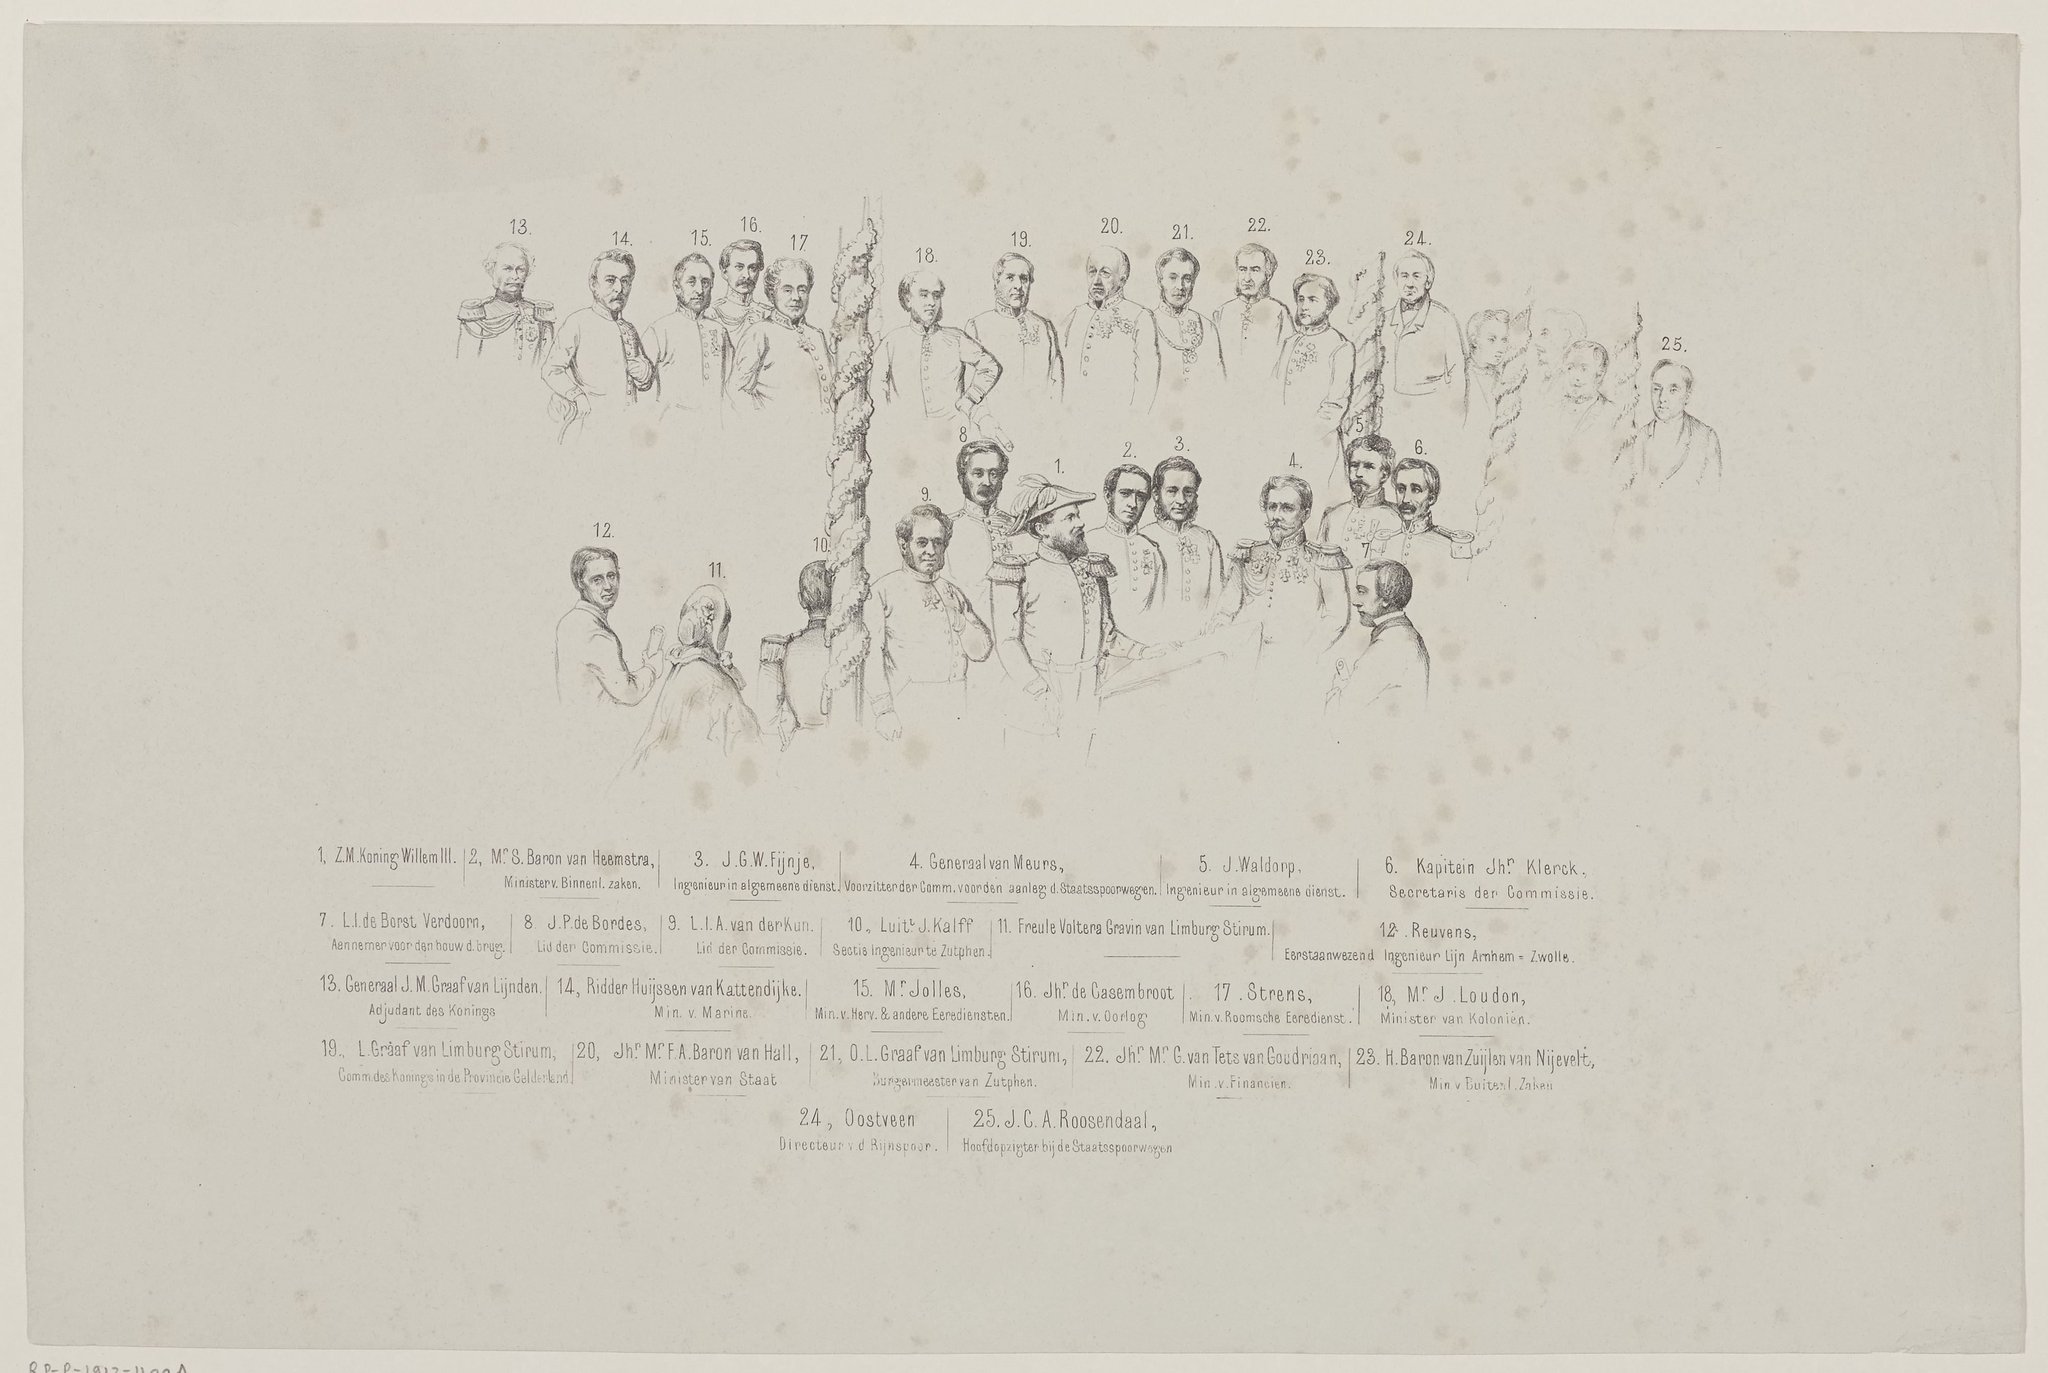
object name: print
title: Sleutel bij de prent van het leggen van de eersten steen door de koning aan de spoorwegbrug te Zutphen, 1861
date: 1861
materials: paper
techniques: lithograph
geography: the hague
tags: brussels, willem iii (koning der nederlanden), ceremonial laying of the foundations, laying the first stone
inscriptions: collector's mark: Lugt 2228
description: De sleutel behorende bij de prent van de ceremonie van het leggen van de eerste steen voor de spoorbrug te Zutphen, verricht door koning Willem III op 22 oktober 1861. Met de namen genummerd 1-25.